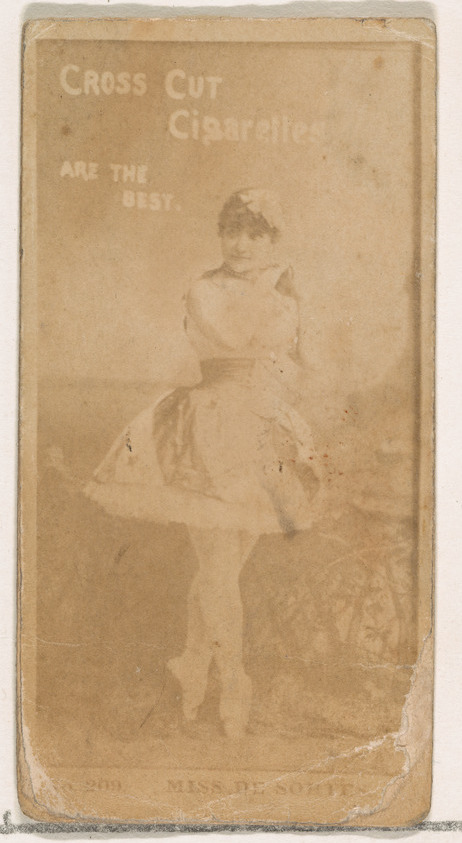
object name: print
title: Card Number 209, Miss De Sortes, from the Actors and Actresses series (N145-2) issued by Duke Sons & Co. to promote Cross Cut Cigarettes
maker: w. duke, sons & co.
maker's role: publisher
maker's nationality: american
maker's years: 1870-1920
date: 1880-1889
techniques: albumen silver print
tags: portraits,women,actresses